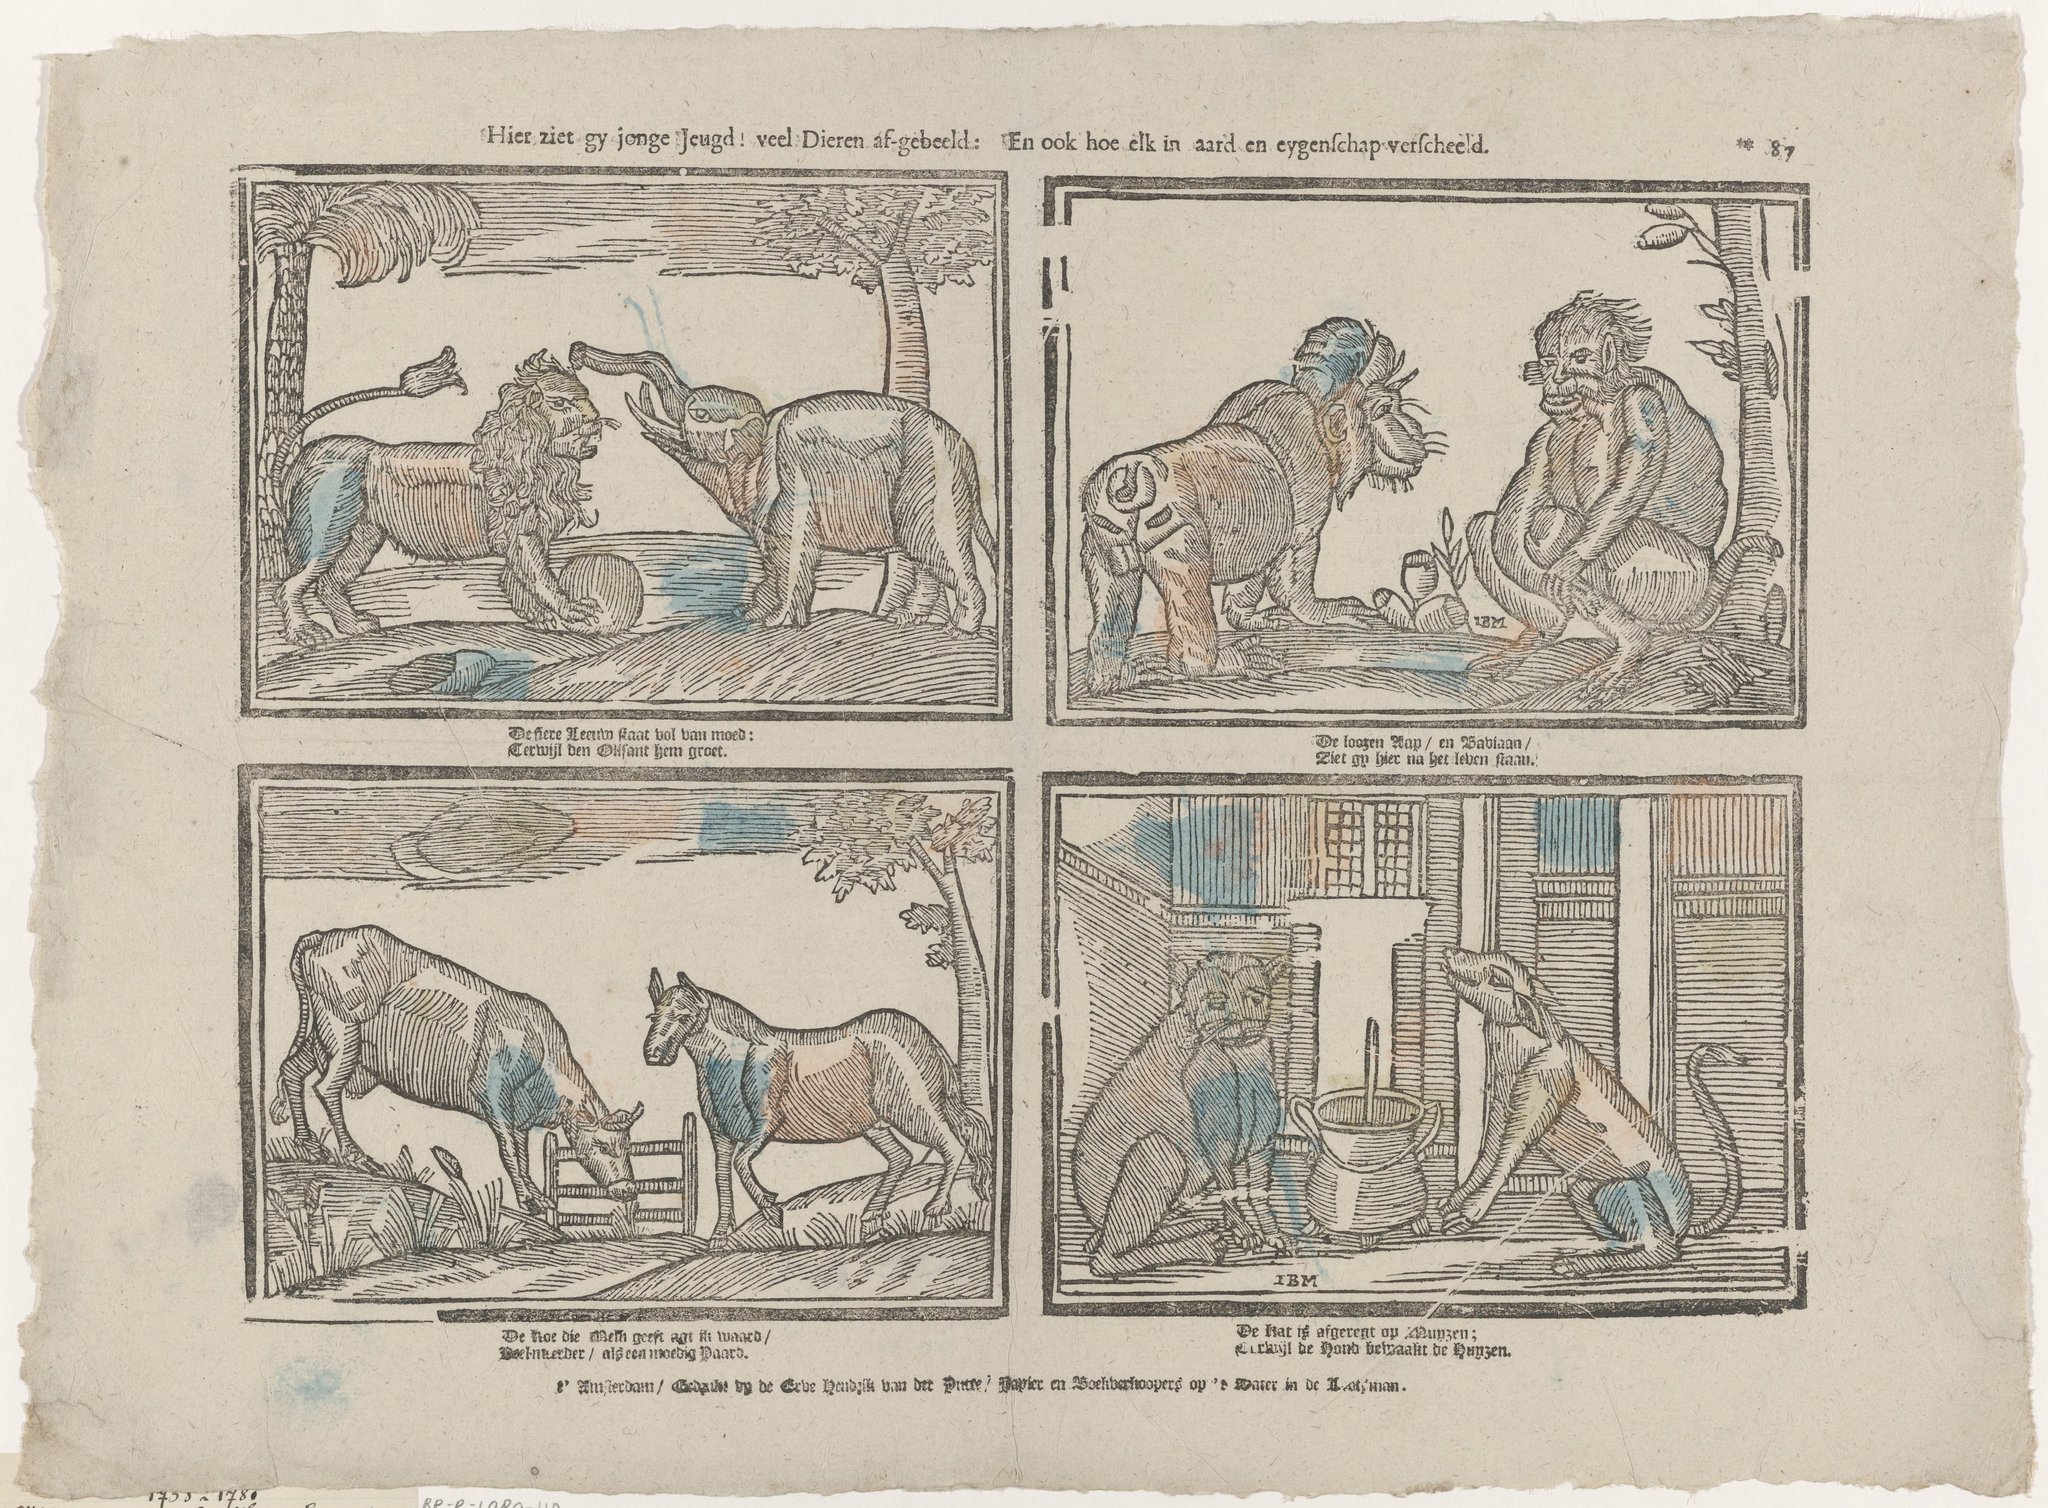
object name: popular print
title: Hier ziet gy jonge jeugd! veel dieren af-gebeeld: / En ook hoe elk in aard en eygenschap verscheeld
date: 1767-1793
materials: paper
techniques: colour, letterpress printing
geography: amsterdam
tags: cow, animals, cat, monkeys, apes, horse, beasts of prey, predatory animals: lion, trunked animals: elephant, dog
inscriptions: collector's mark: Lugt 2760, collector's mark: Lugt 2228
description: Blad met 4 voorstellingen van telkens twee dieren, waaronder een leeuw, een olifant, apen en een kat. Onder elke afbeelding een tweeregelig vers. Genummerd rechtsboven: *87.